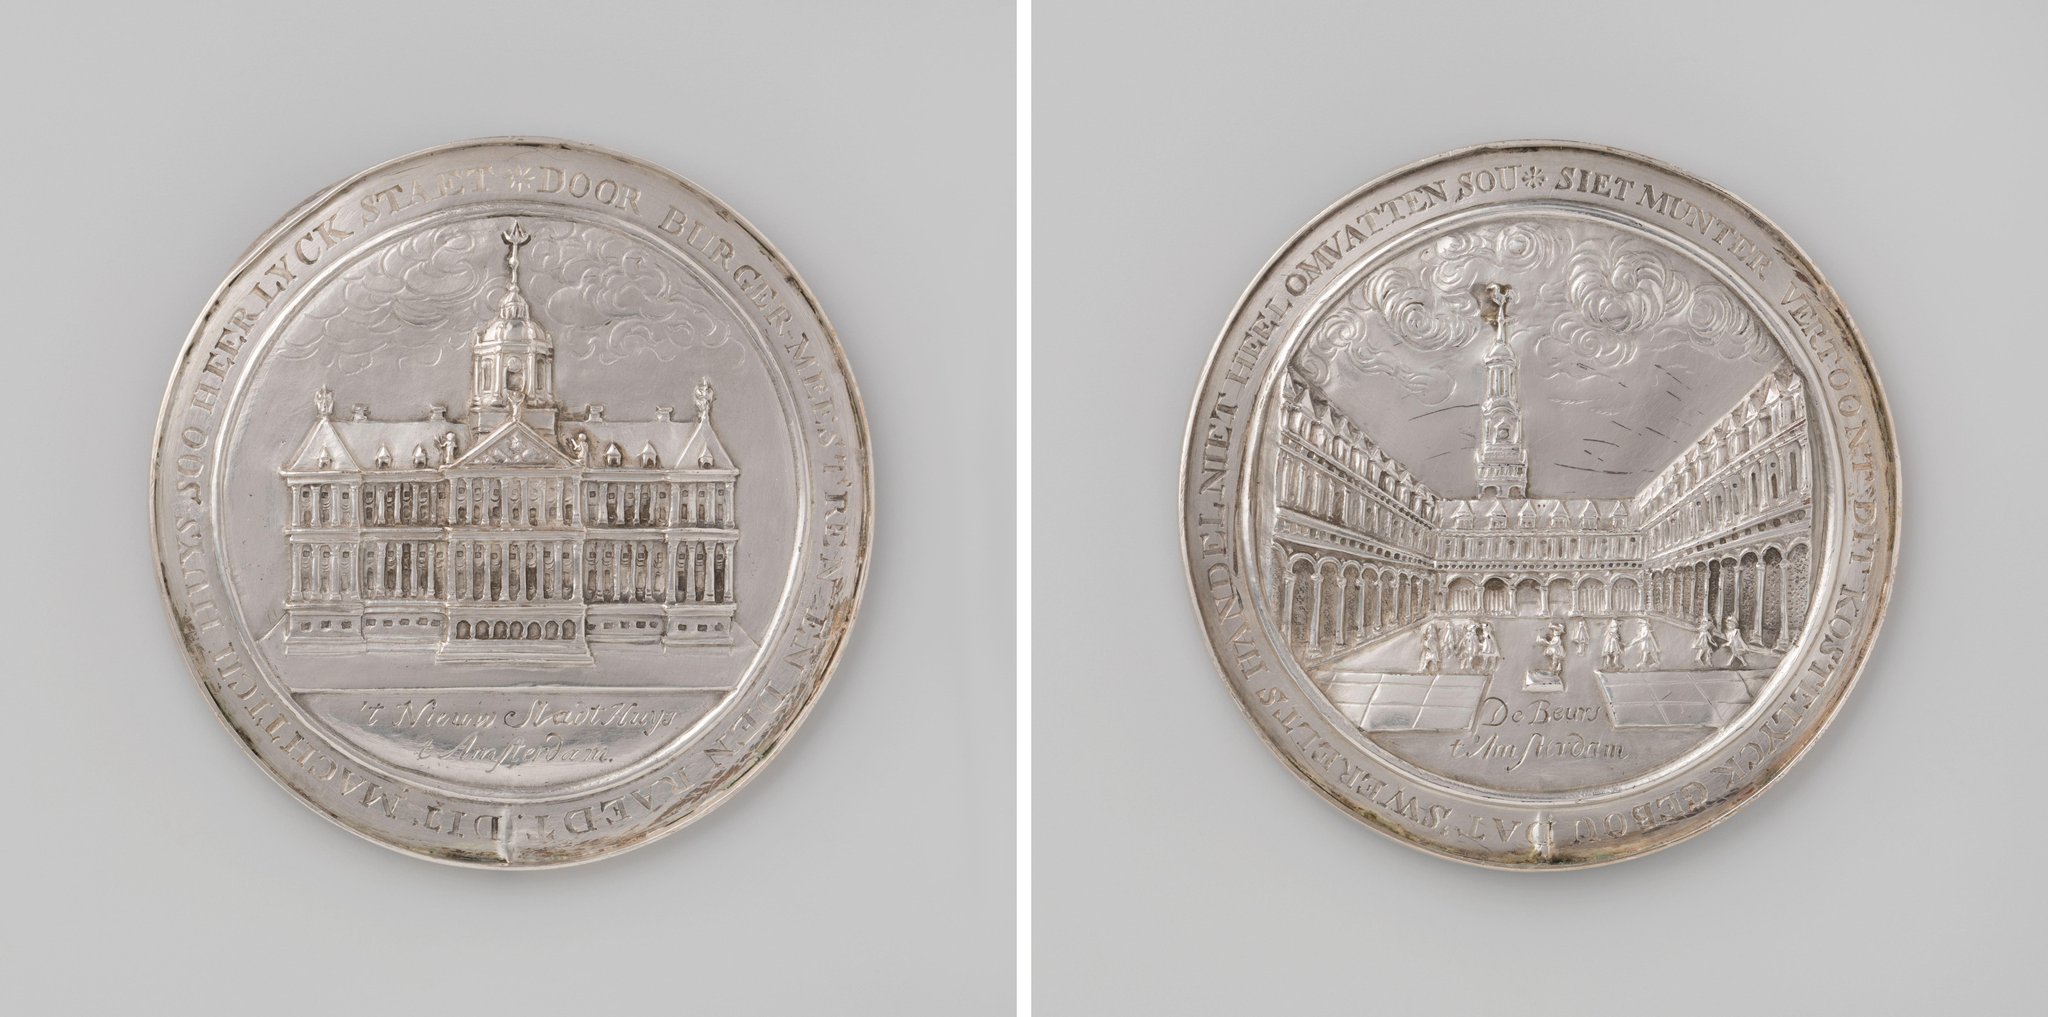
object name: history medal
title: Inwijding van het nieuwe stadhuis te Amsterdam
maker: wouter muller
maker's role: publisher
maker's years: 1604-1673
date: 1655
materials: silver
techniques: striking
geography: amsterdam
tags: stock exchange, stock-market, royal palace of amsterdam, amsterdam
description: Zilveren penning. Voorzijde: het nieuwe stadhuis binnen omschrift. Keerzijde: de beurs van Amsterdam binnen omschrift